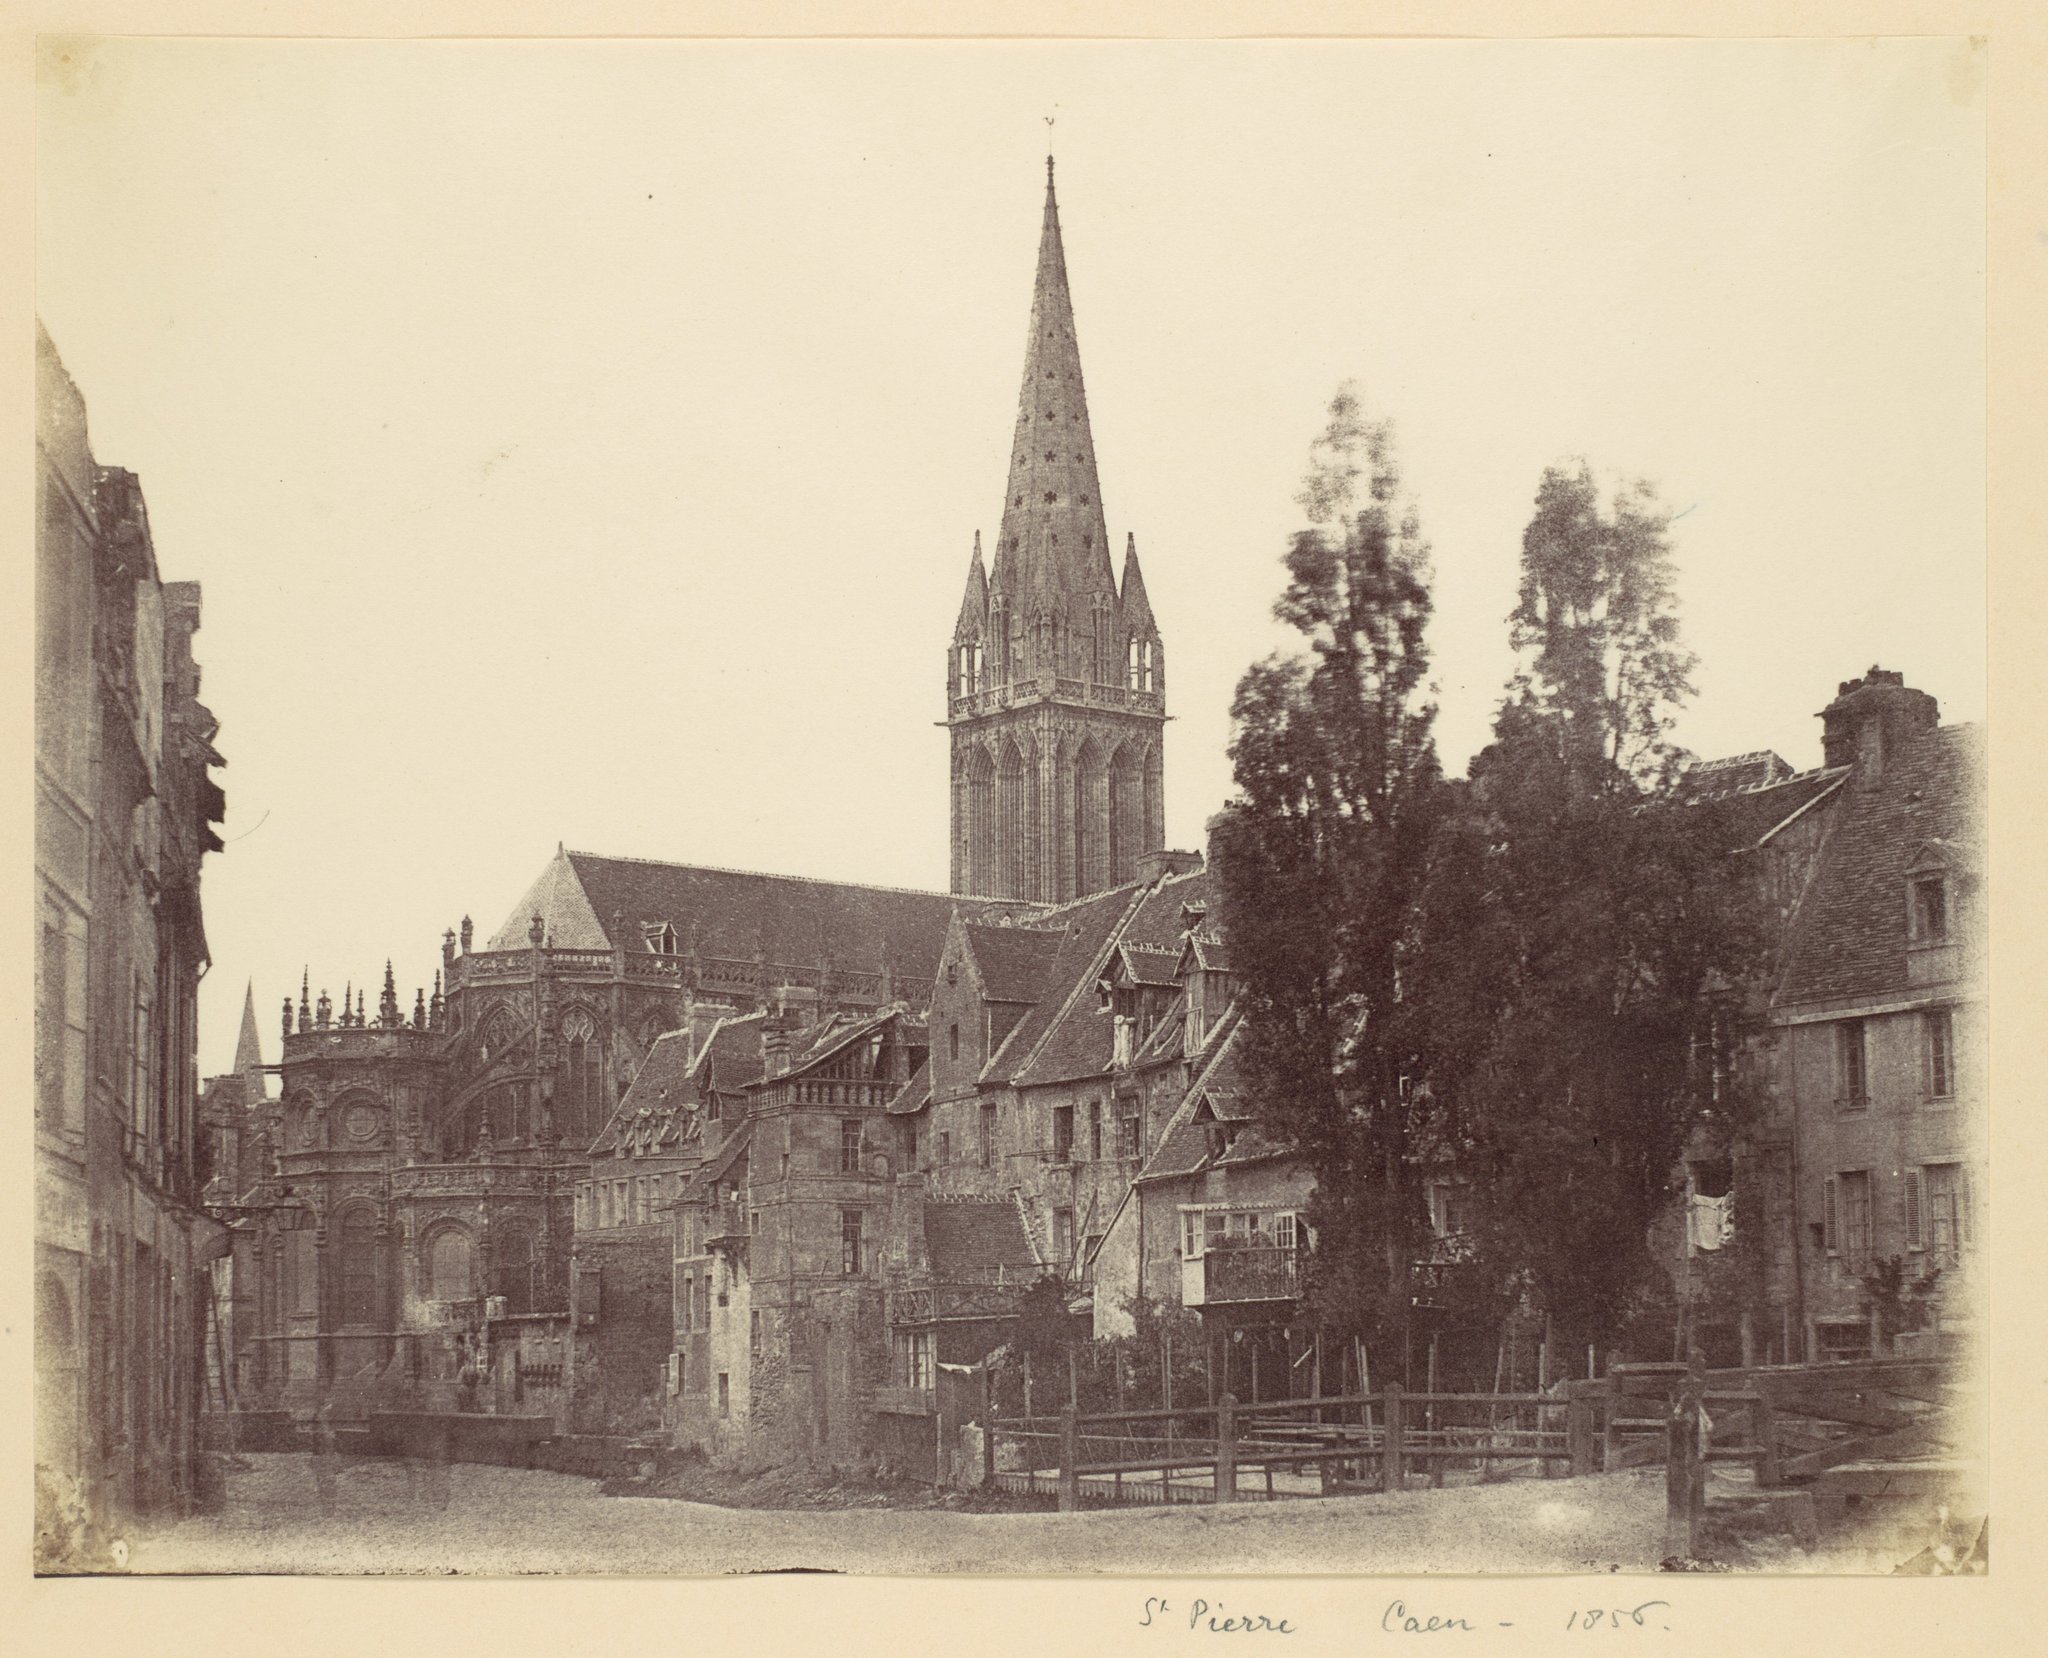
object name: photograph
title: St. Pierre, Caen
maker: alfred capel cure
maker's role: artist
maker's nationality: british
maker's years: 1826-1896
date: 1856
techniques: albumen silver print, paper negative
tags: architecture,buildings